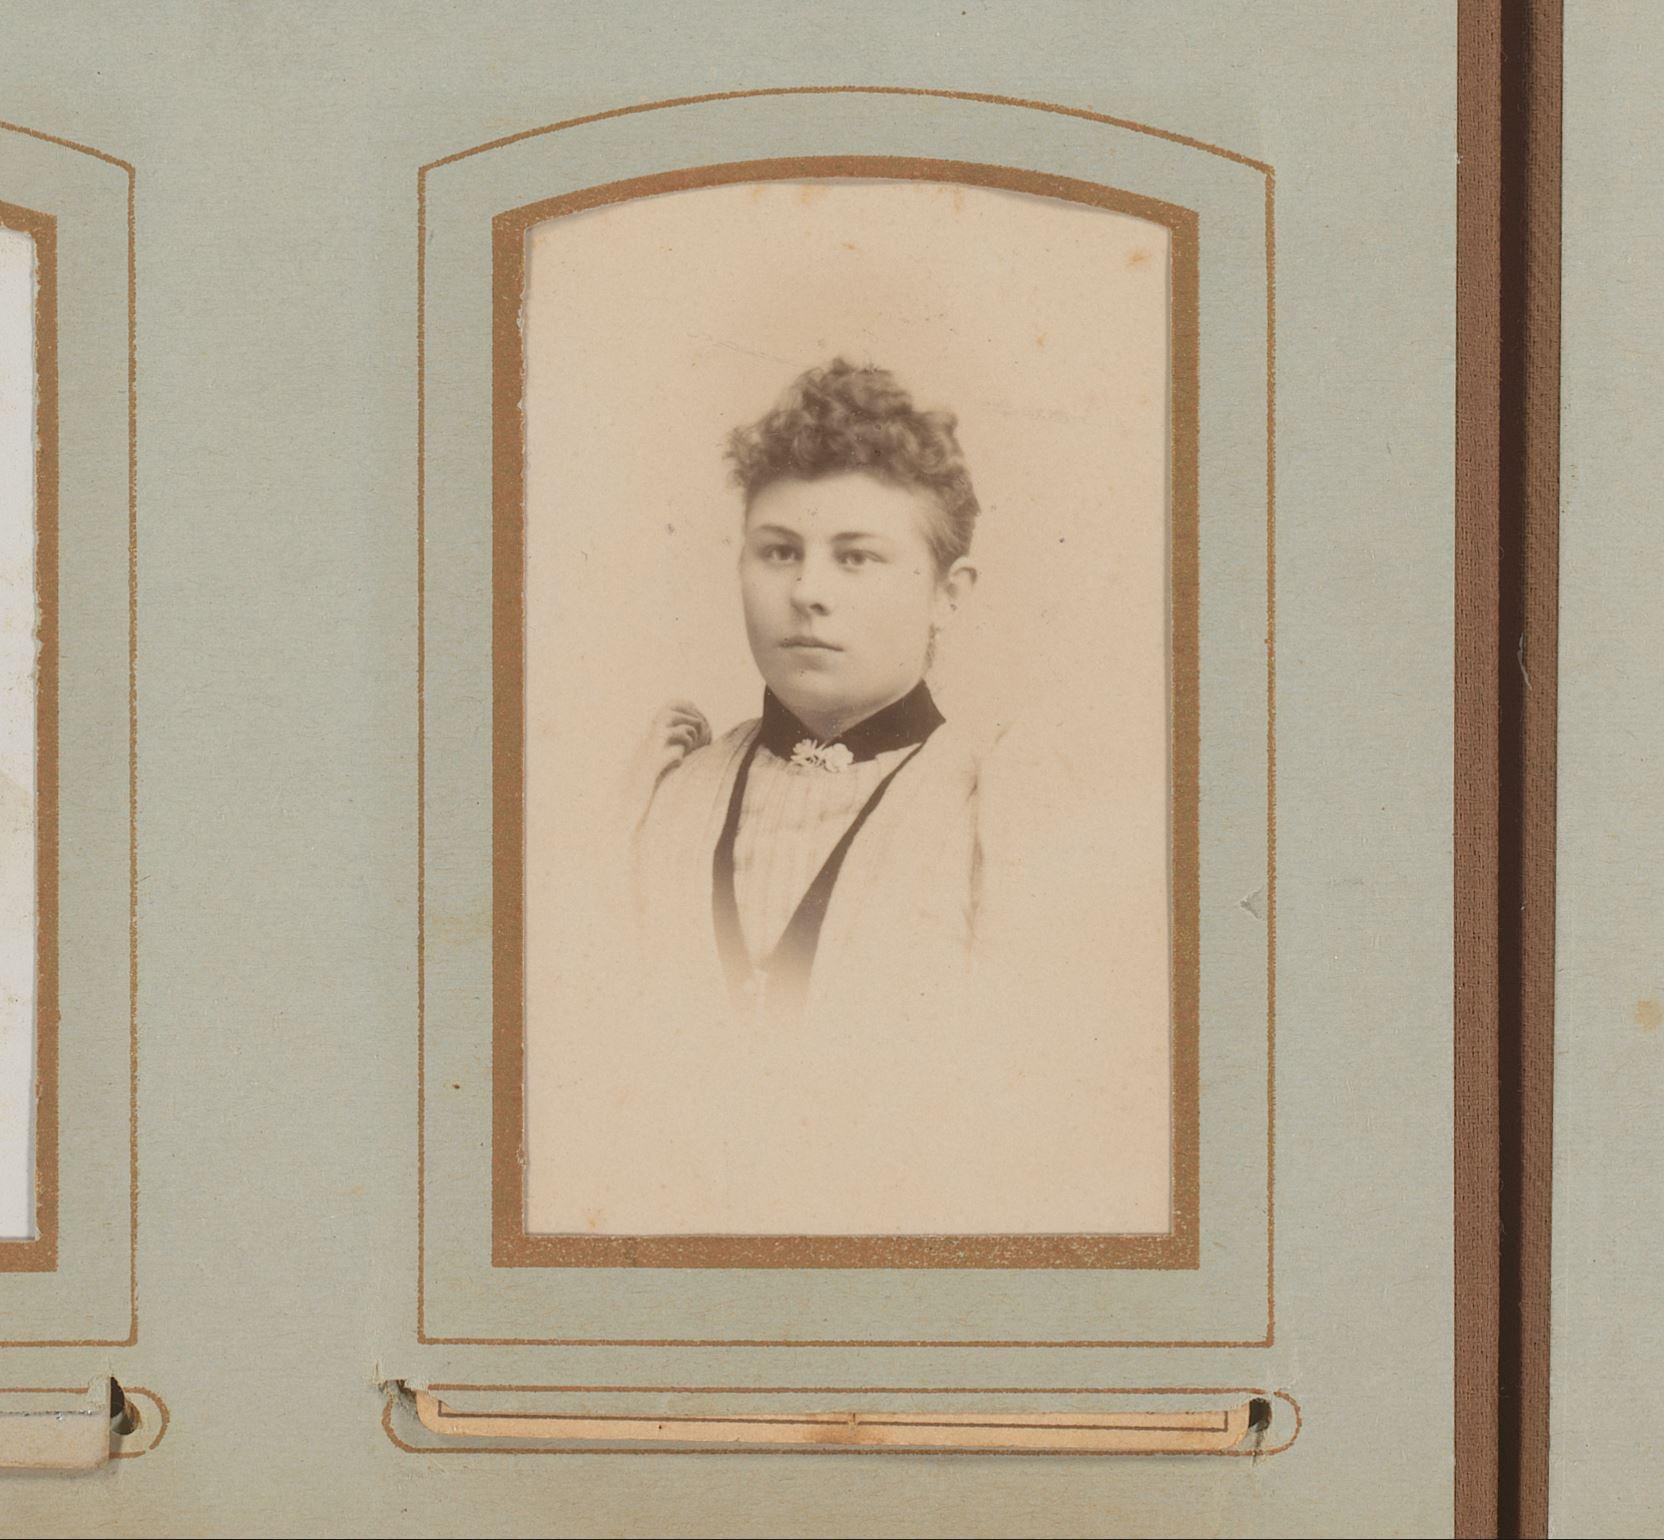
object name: carte de visite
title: Portret van een vrouw, aangeduid als Gee Pentermann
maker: elkan sanders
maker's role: fotograaf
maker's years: 1848-1923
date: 1893-1901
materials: cardboard, photographic support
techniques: albumen print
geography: groningen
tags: historical persons - bb - woman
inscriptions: name: ‘Gee Petermann’, inscription: ‘Elkan Sanders Jr./ Groningen Oosterstraat 204, Hoek Donkersgang’